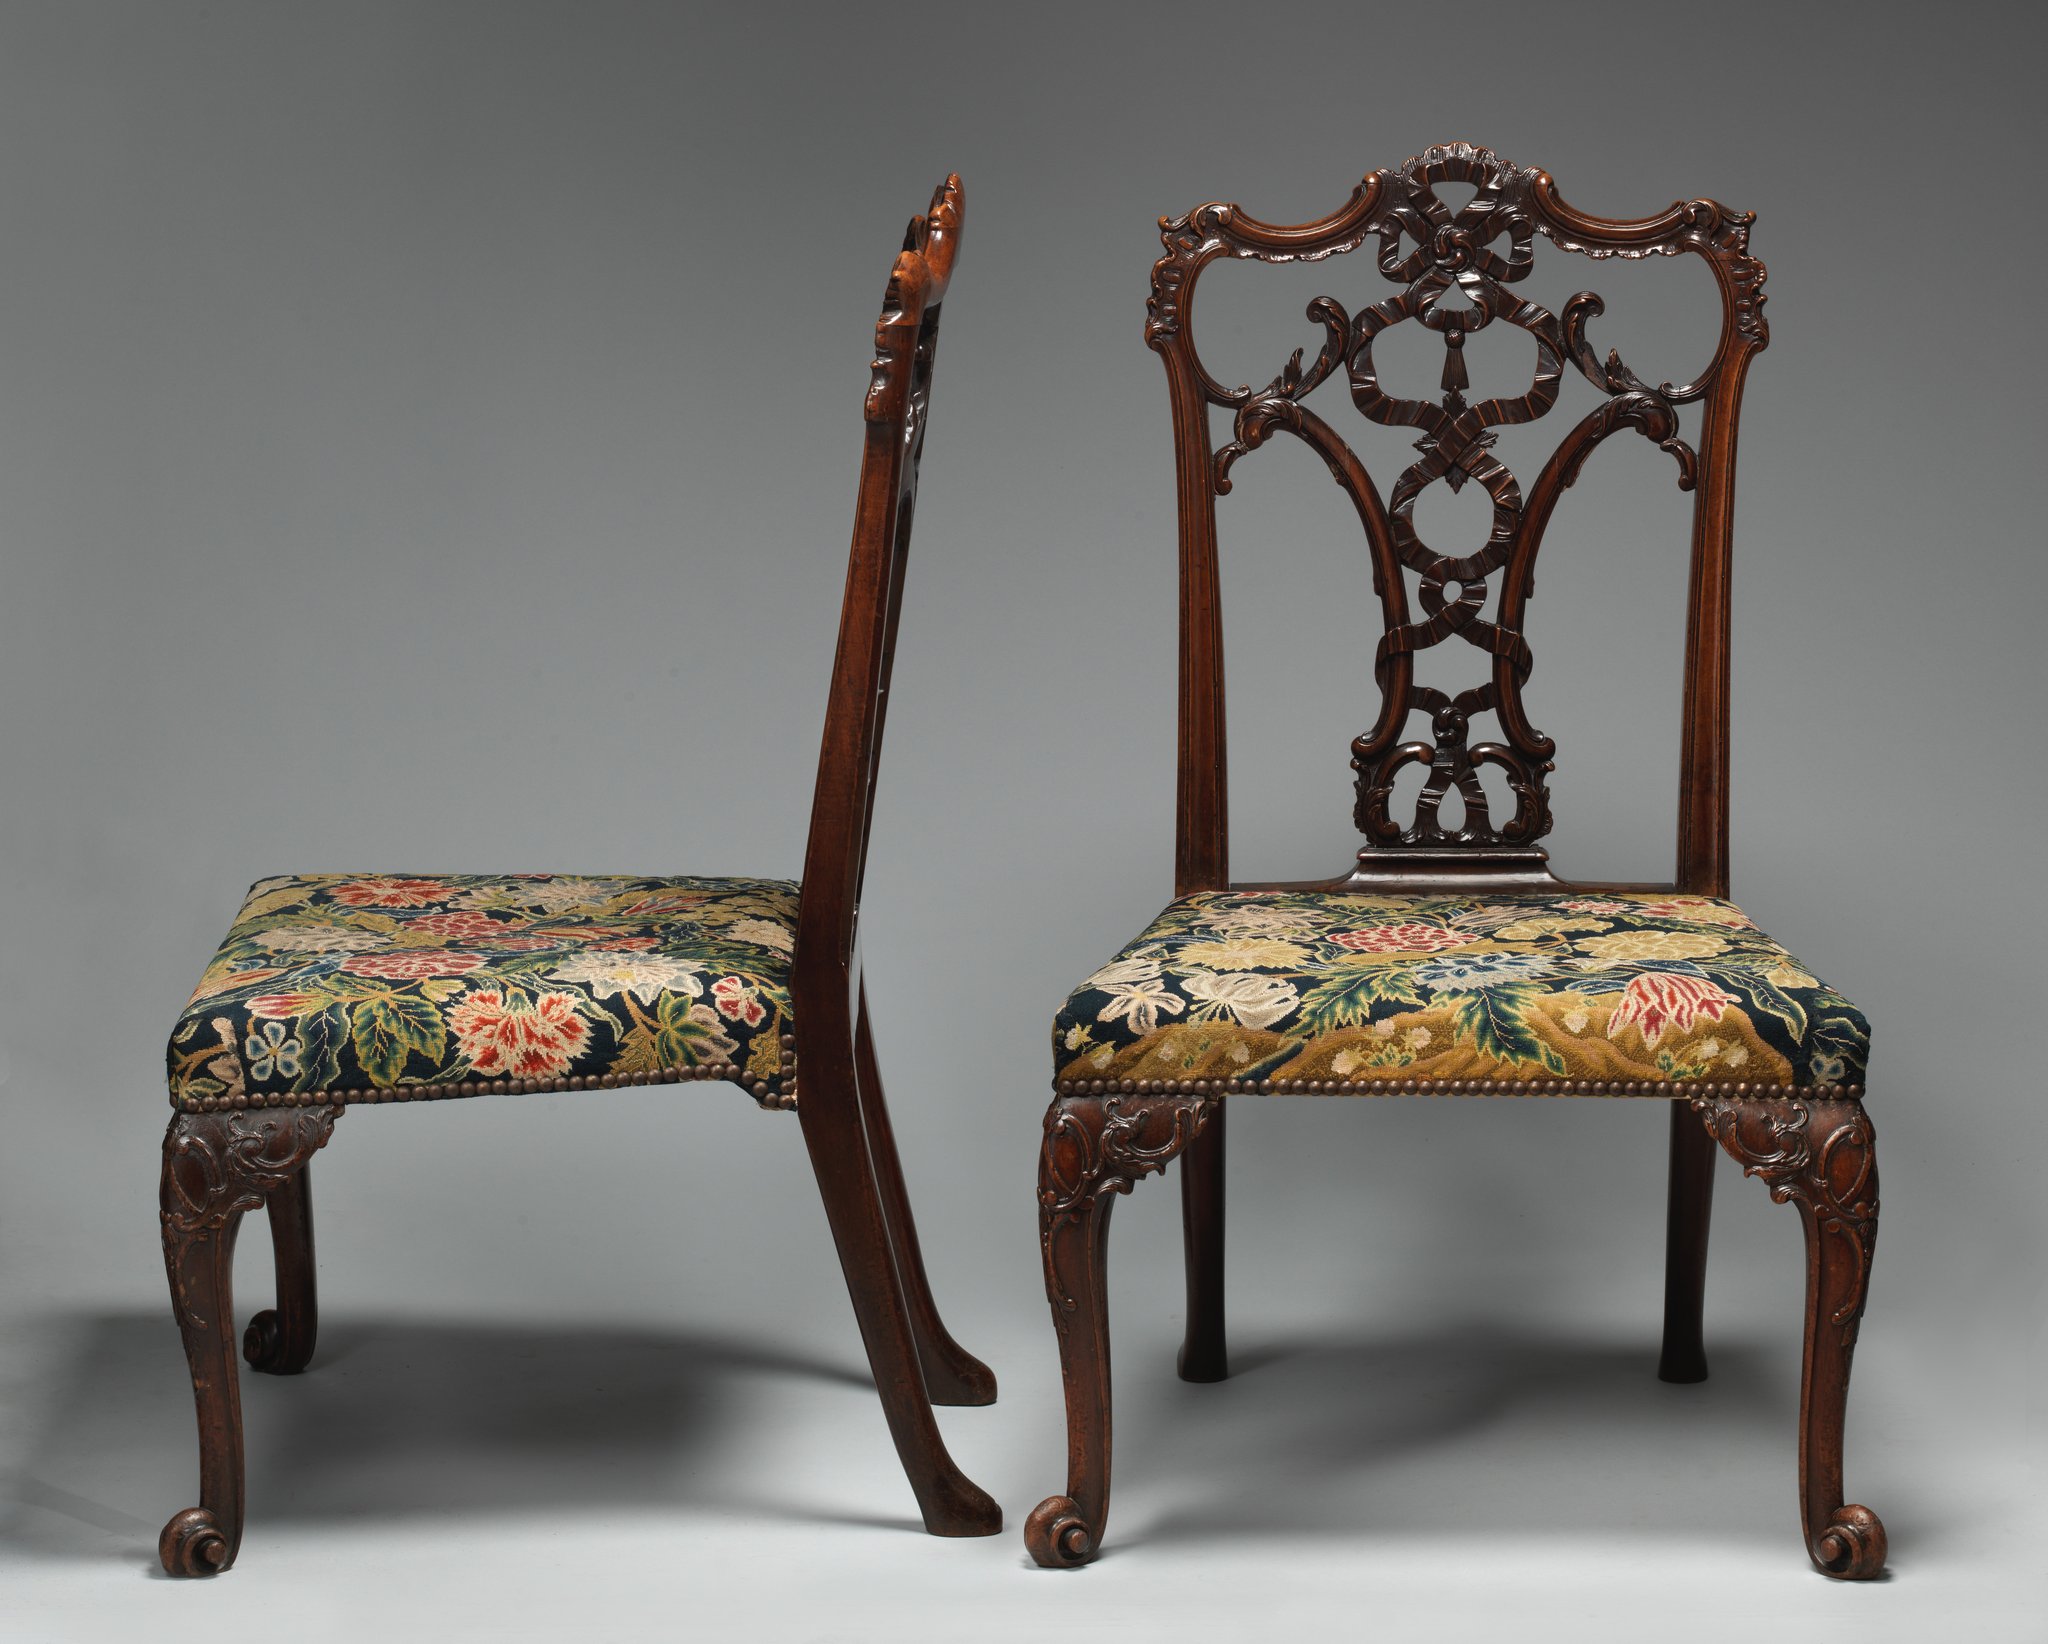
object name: side chair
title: Side Chair (one of a pair)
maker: thomas chippendale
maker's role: designer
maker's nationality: british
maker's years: 1718-1779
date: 1755-1760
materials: canvas, wood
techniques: embroidery, stitching